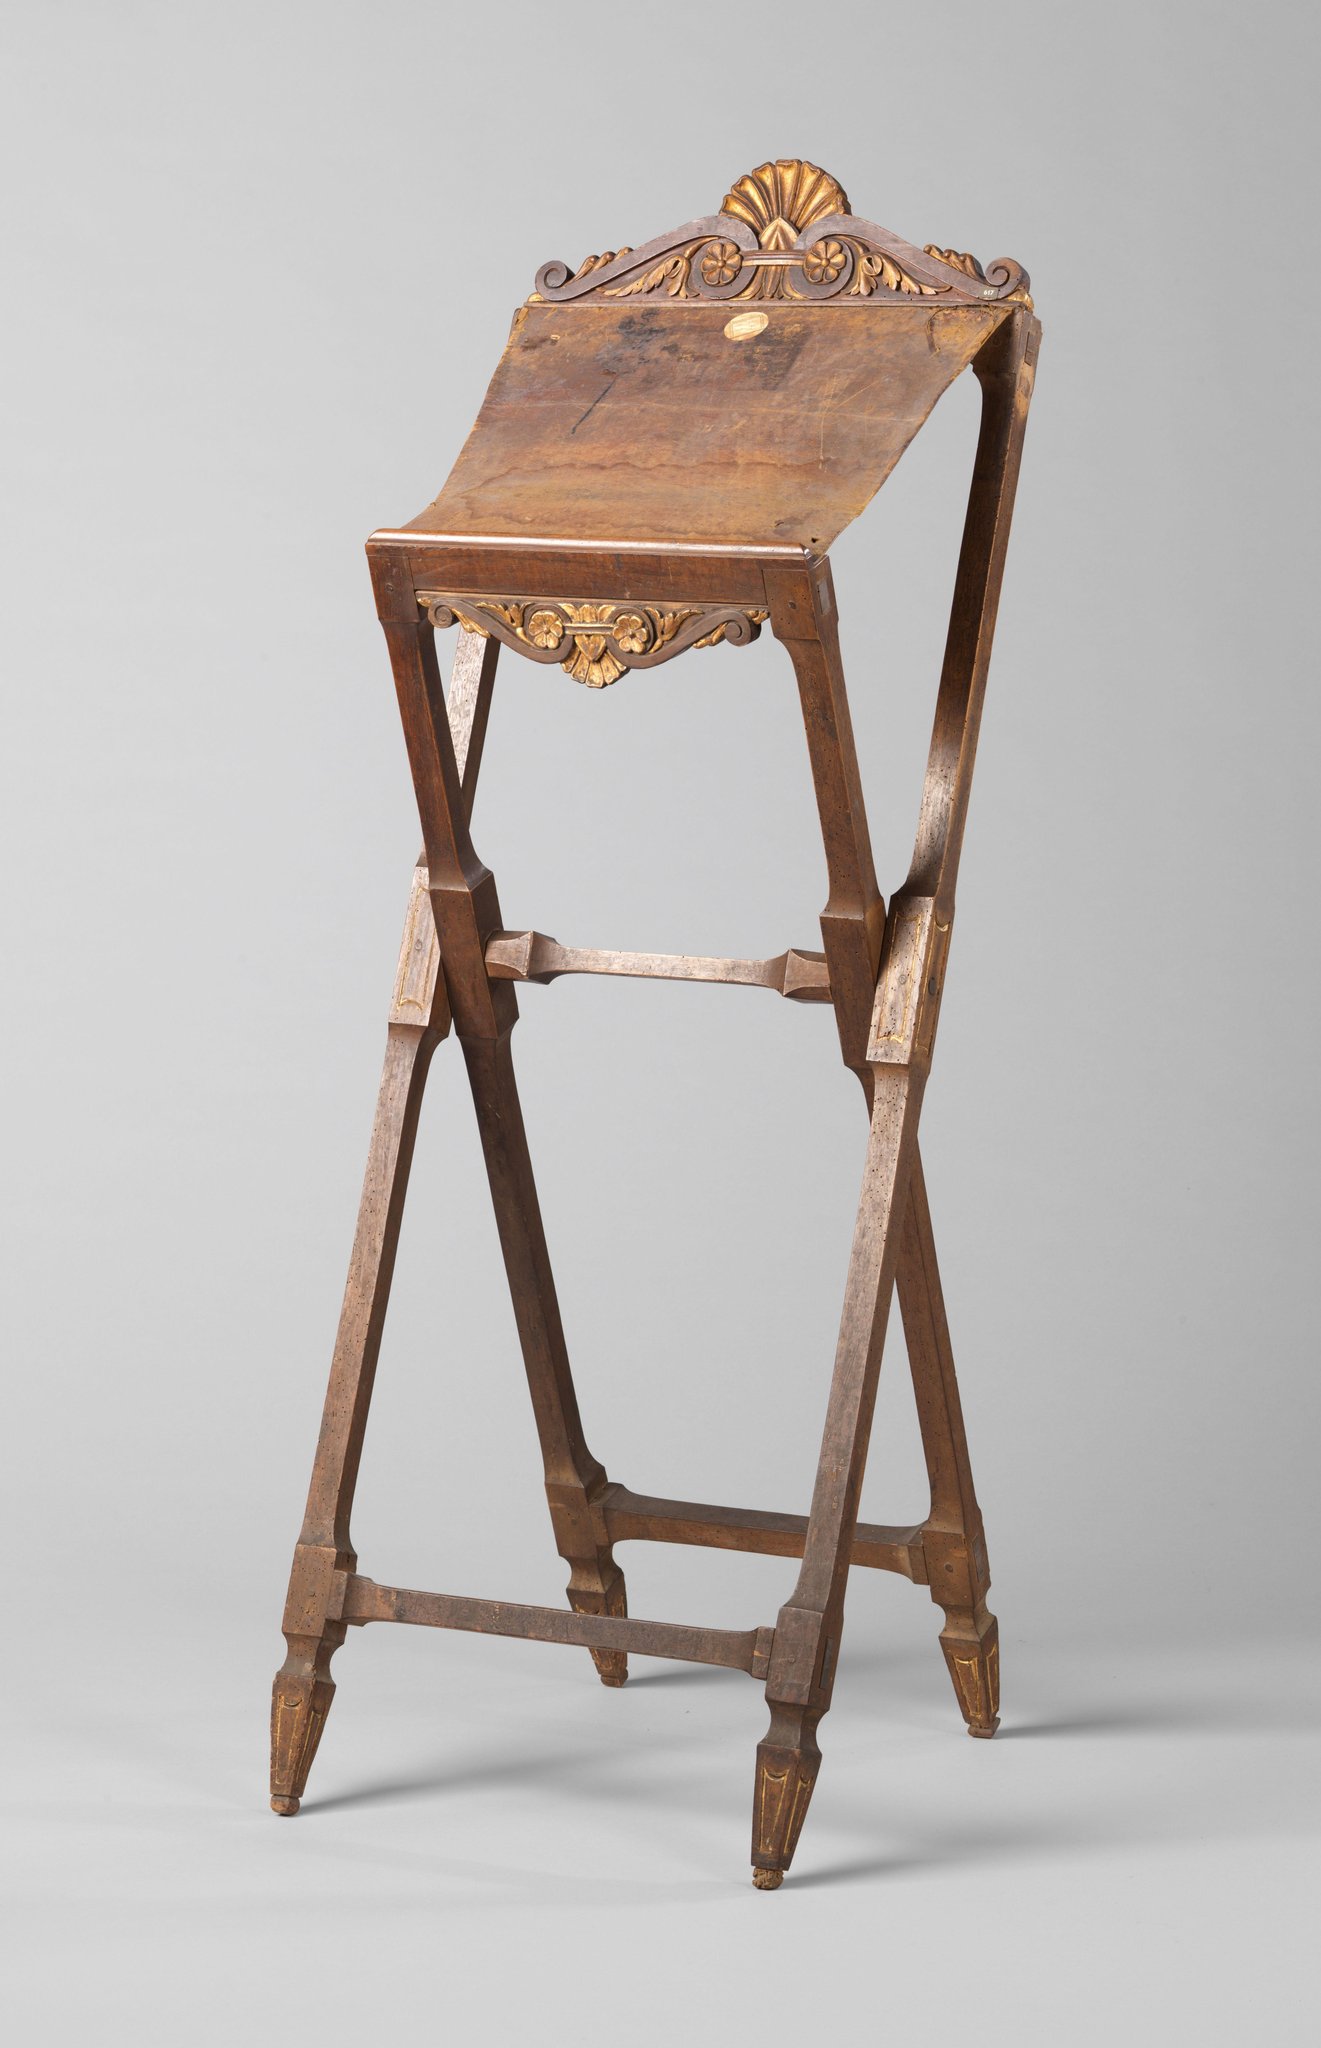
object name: furniture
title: Opvouwbare lezenaar van notenhout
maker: Anonymous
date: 1500-1600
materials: leather, wood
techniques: gilding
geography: italy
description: Opvouwbare lezenaar van notenhout. De schraagpoten zijn rechthoekig van doorsnede, naar onderen conisch toelopend en op de snijpunten verbonden door een dwarsregel. Aan de bovenzijde zijn de poten eveneens verbonden door dwarsregels, die versierd zijn met een gestoken opzetstuk, gevormd door een bladmotief geflankeerd door toegewende voluten. Aan de bovenzijde zijn de regels verbonden door een vel leer.